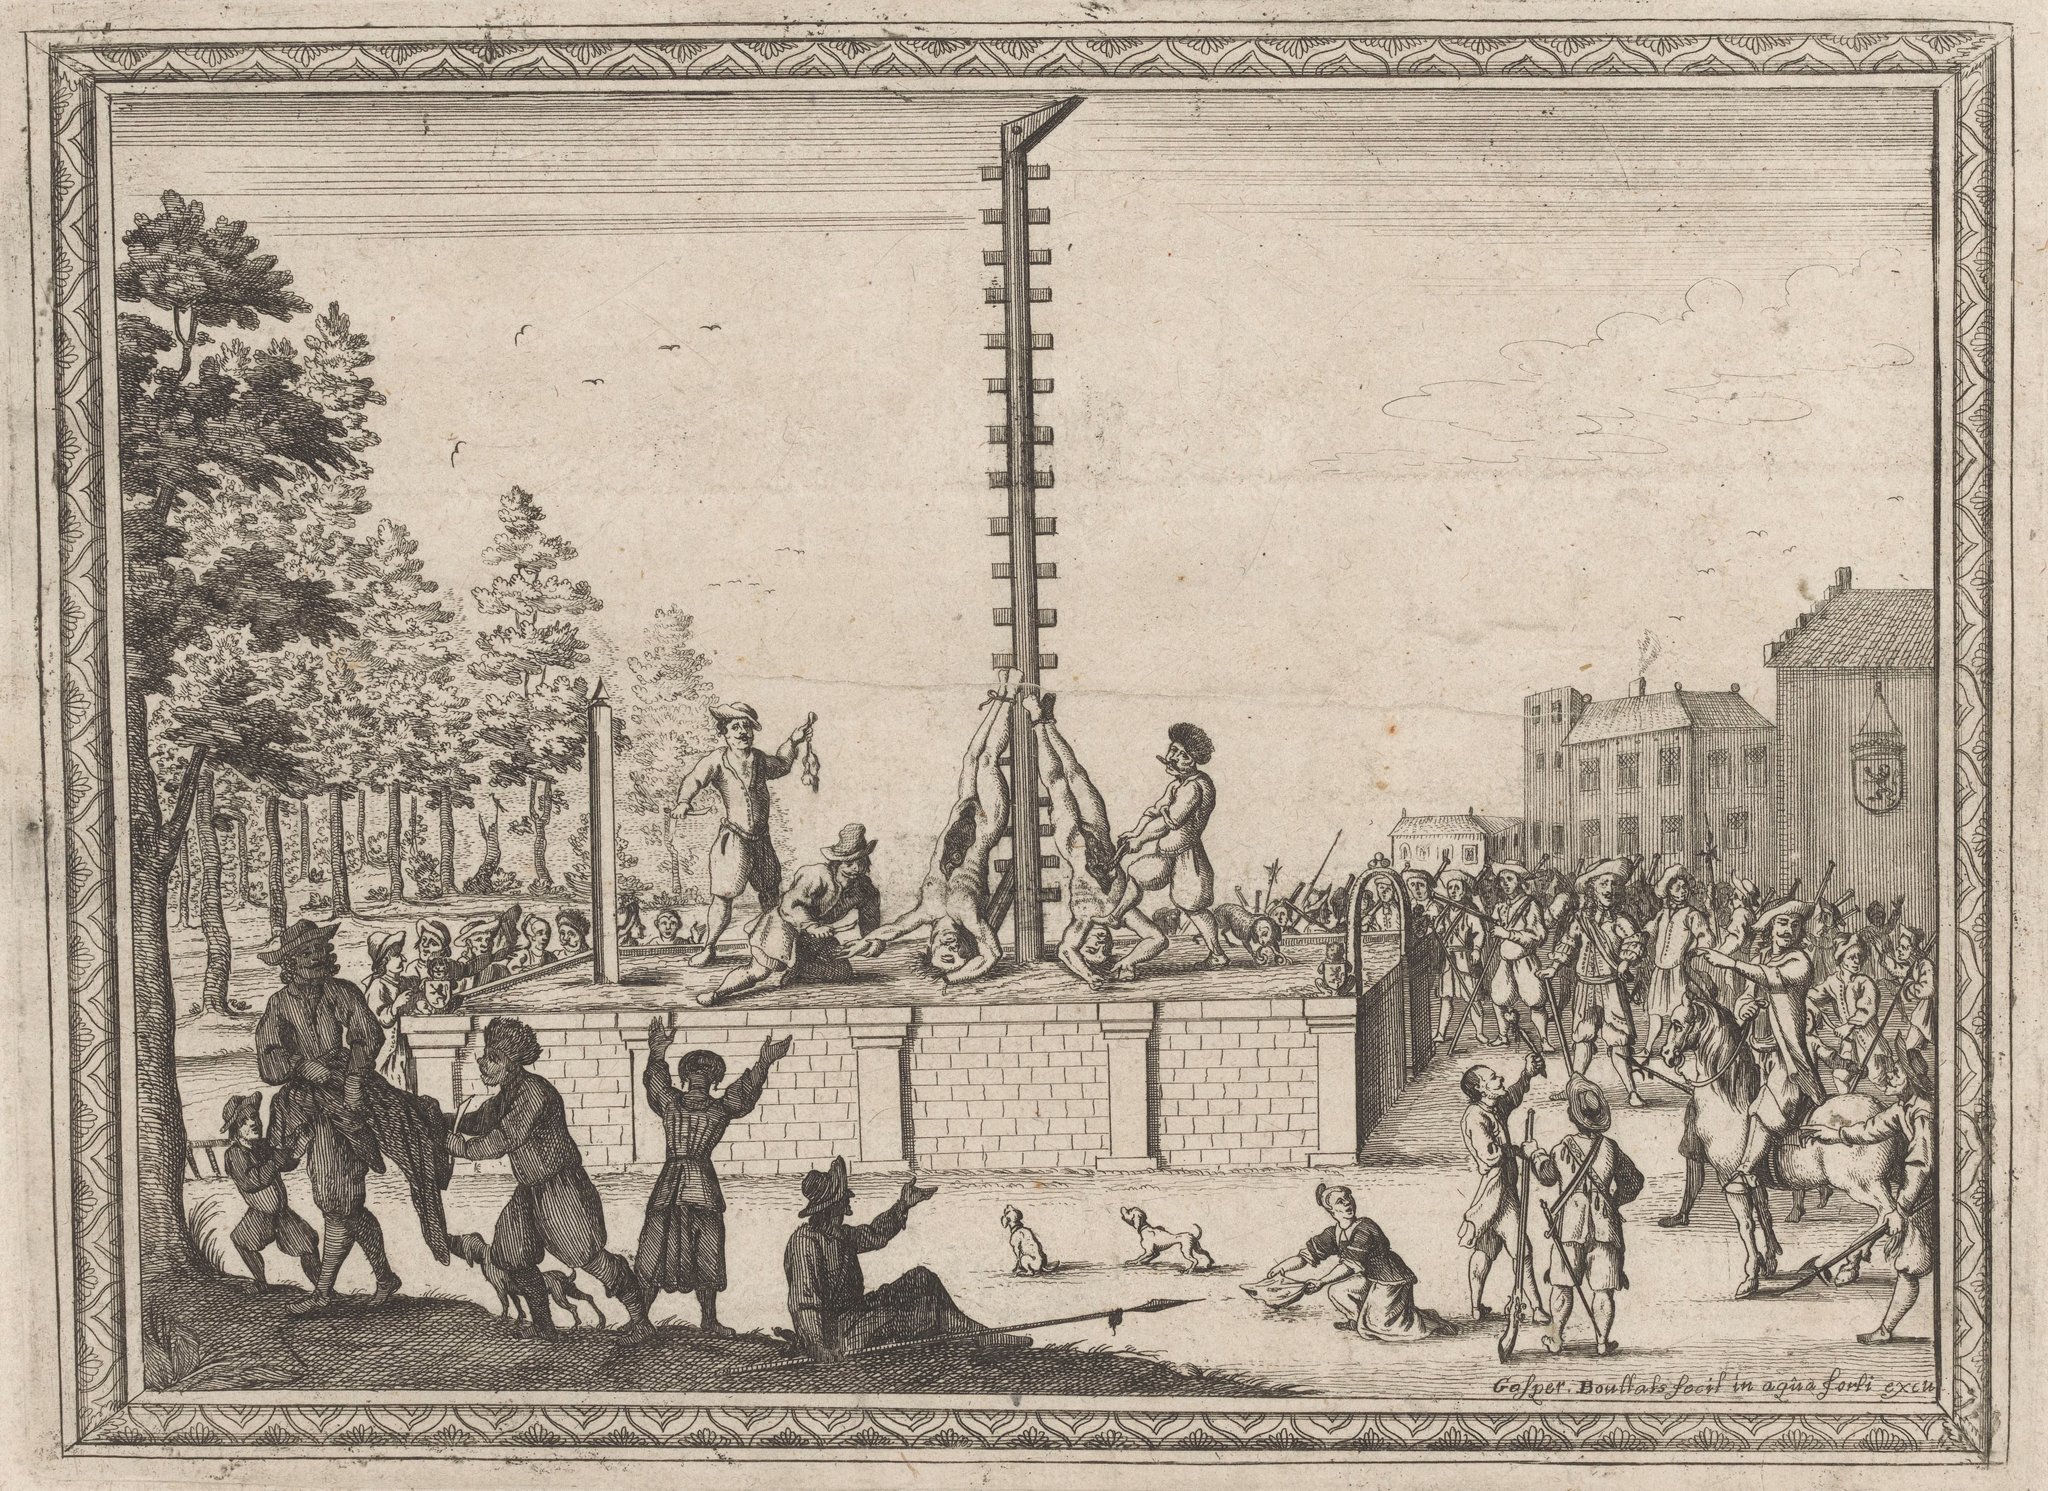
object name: print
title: De moord op de gebroeders De Witt, 1672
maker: gaspar bouttats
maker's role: print maker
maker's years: 1640-1695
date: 1672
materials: paper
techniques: etching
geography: antwerp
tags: dordrecht, the hague, cornelis de witt, politician, johan de witt, mutilation of the corpse, lynching, attempt, political murder, violent death, being killed; being mishandled and maltreated; seeking death (+ death by lynching)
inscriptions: date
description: De verminking van de lichamen van Johan en Cornelis de Witt op 20 augustus 1672. Onder de voorstelling Latijnse, Franse en Nederlandse verzen waarin de moorden worden gerechtvaardigd.